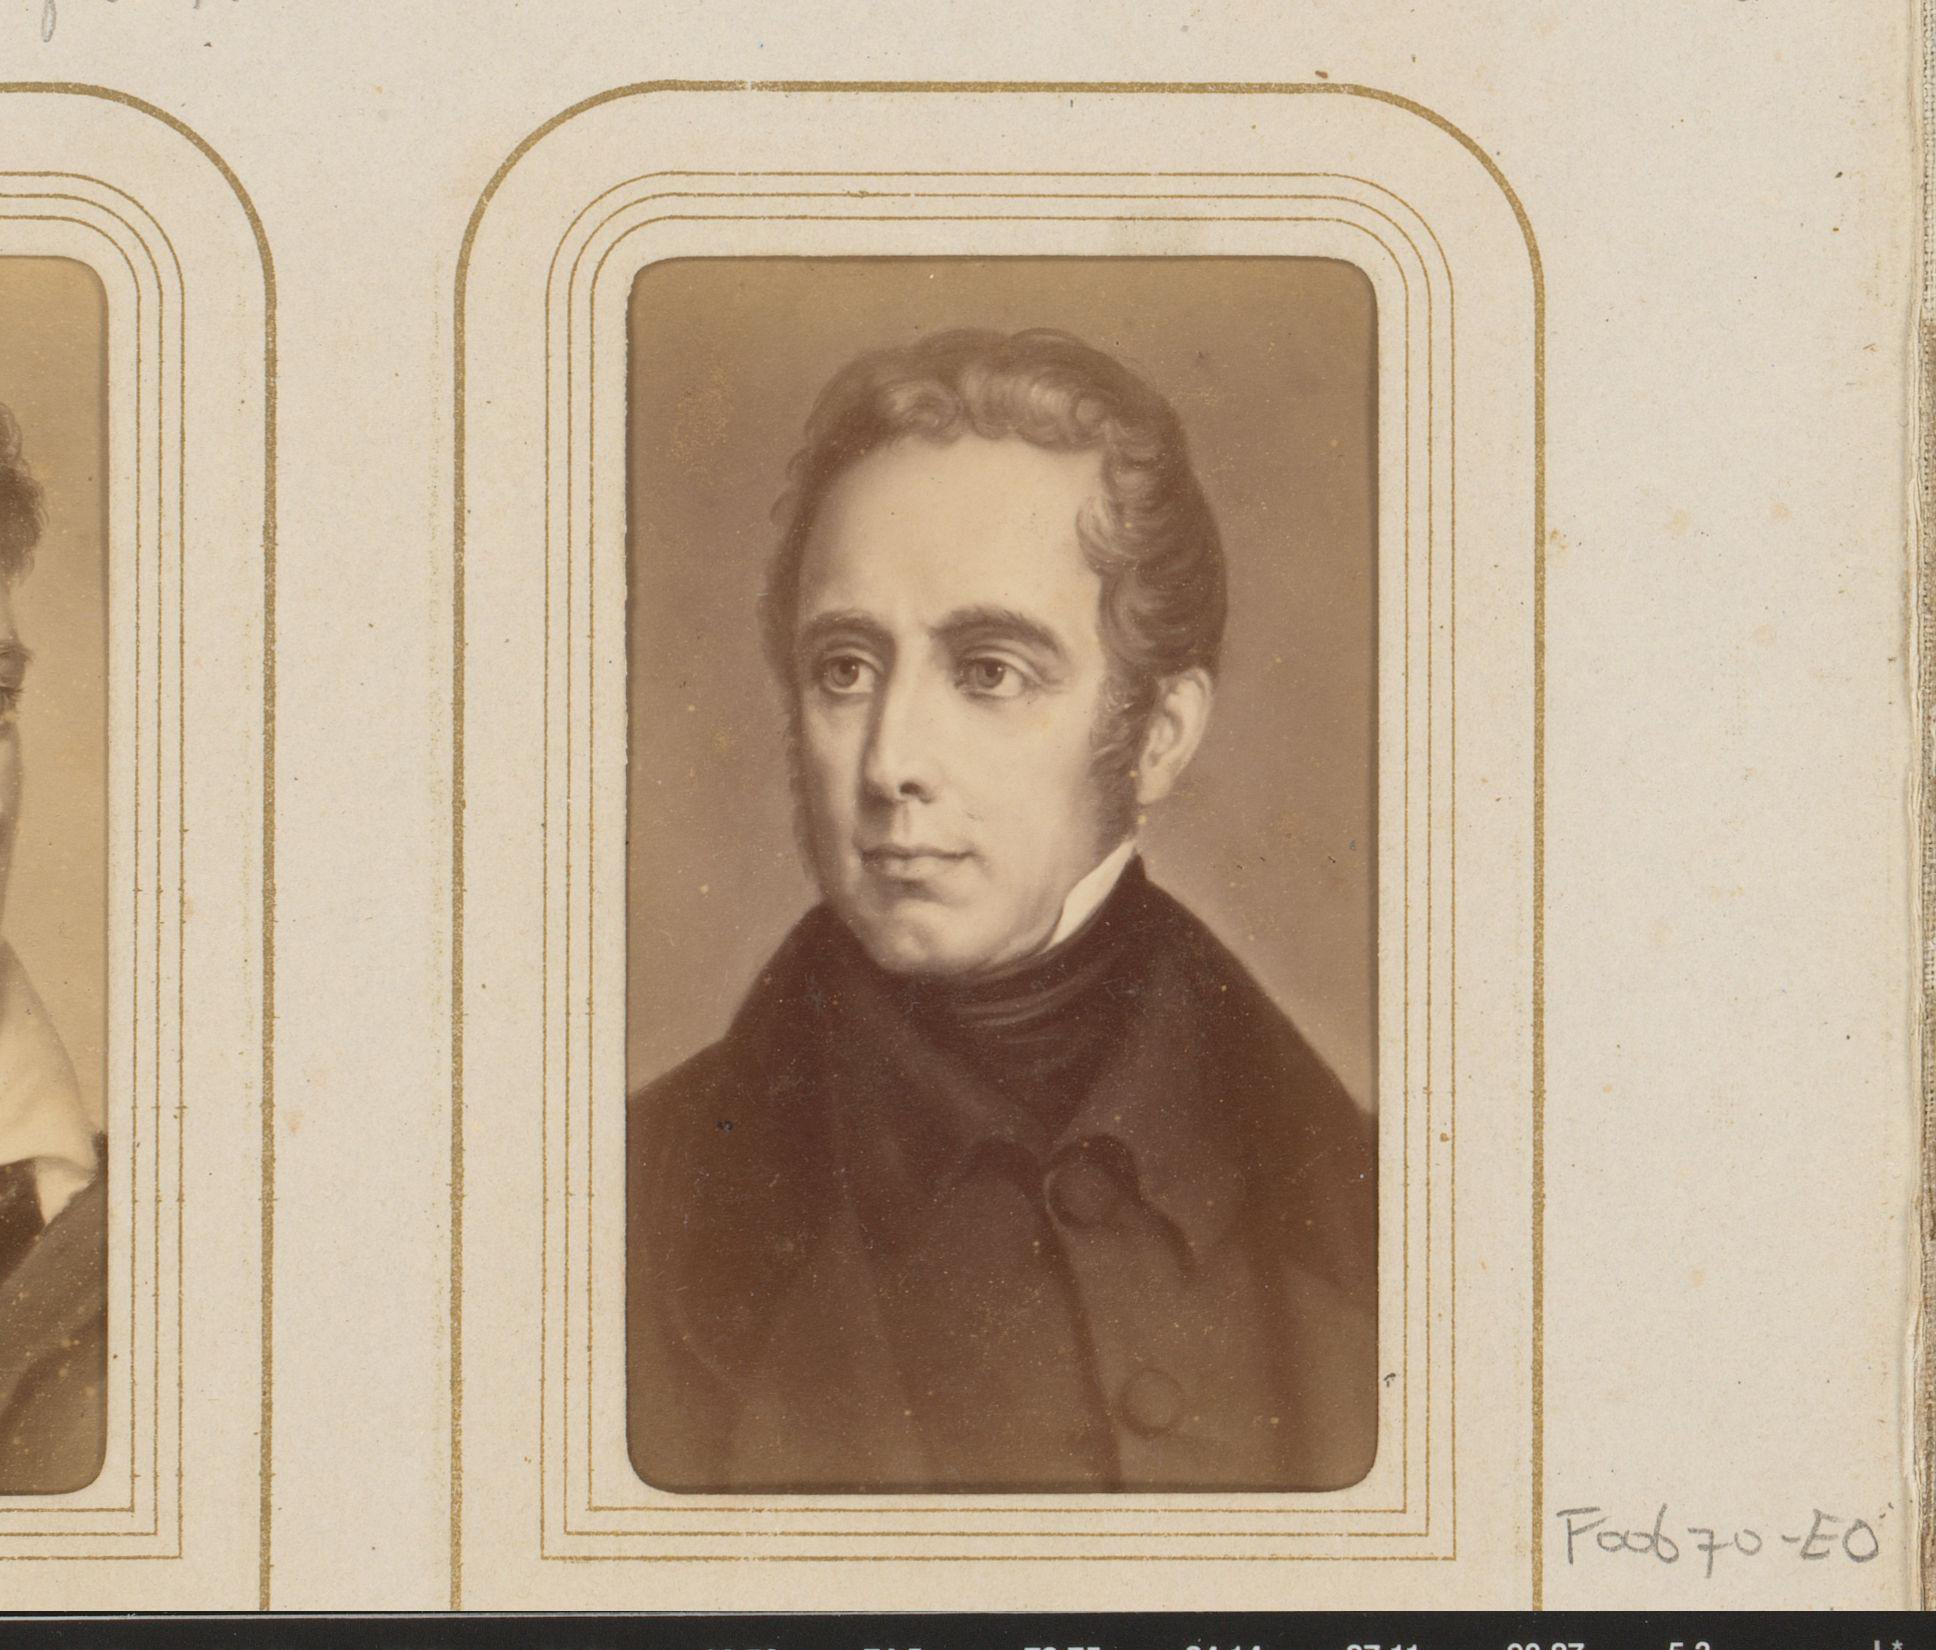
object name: album leaf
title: Fotoreproductie van een geschilderd portret van Alphonse de Lamartine naar Ernst Hader door Sophus Williams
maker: sophus williams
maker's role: publisher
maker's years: 1835-1900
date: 1879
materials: cardboard, photographic support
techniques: albumen print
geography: berlin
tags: paris, historical persons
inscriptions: name: ‘Alphonse de Lamartine’, name: ‘Alphonse de Lamartine’, number: ‘1.50/ 56’